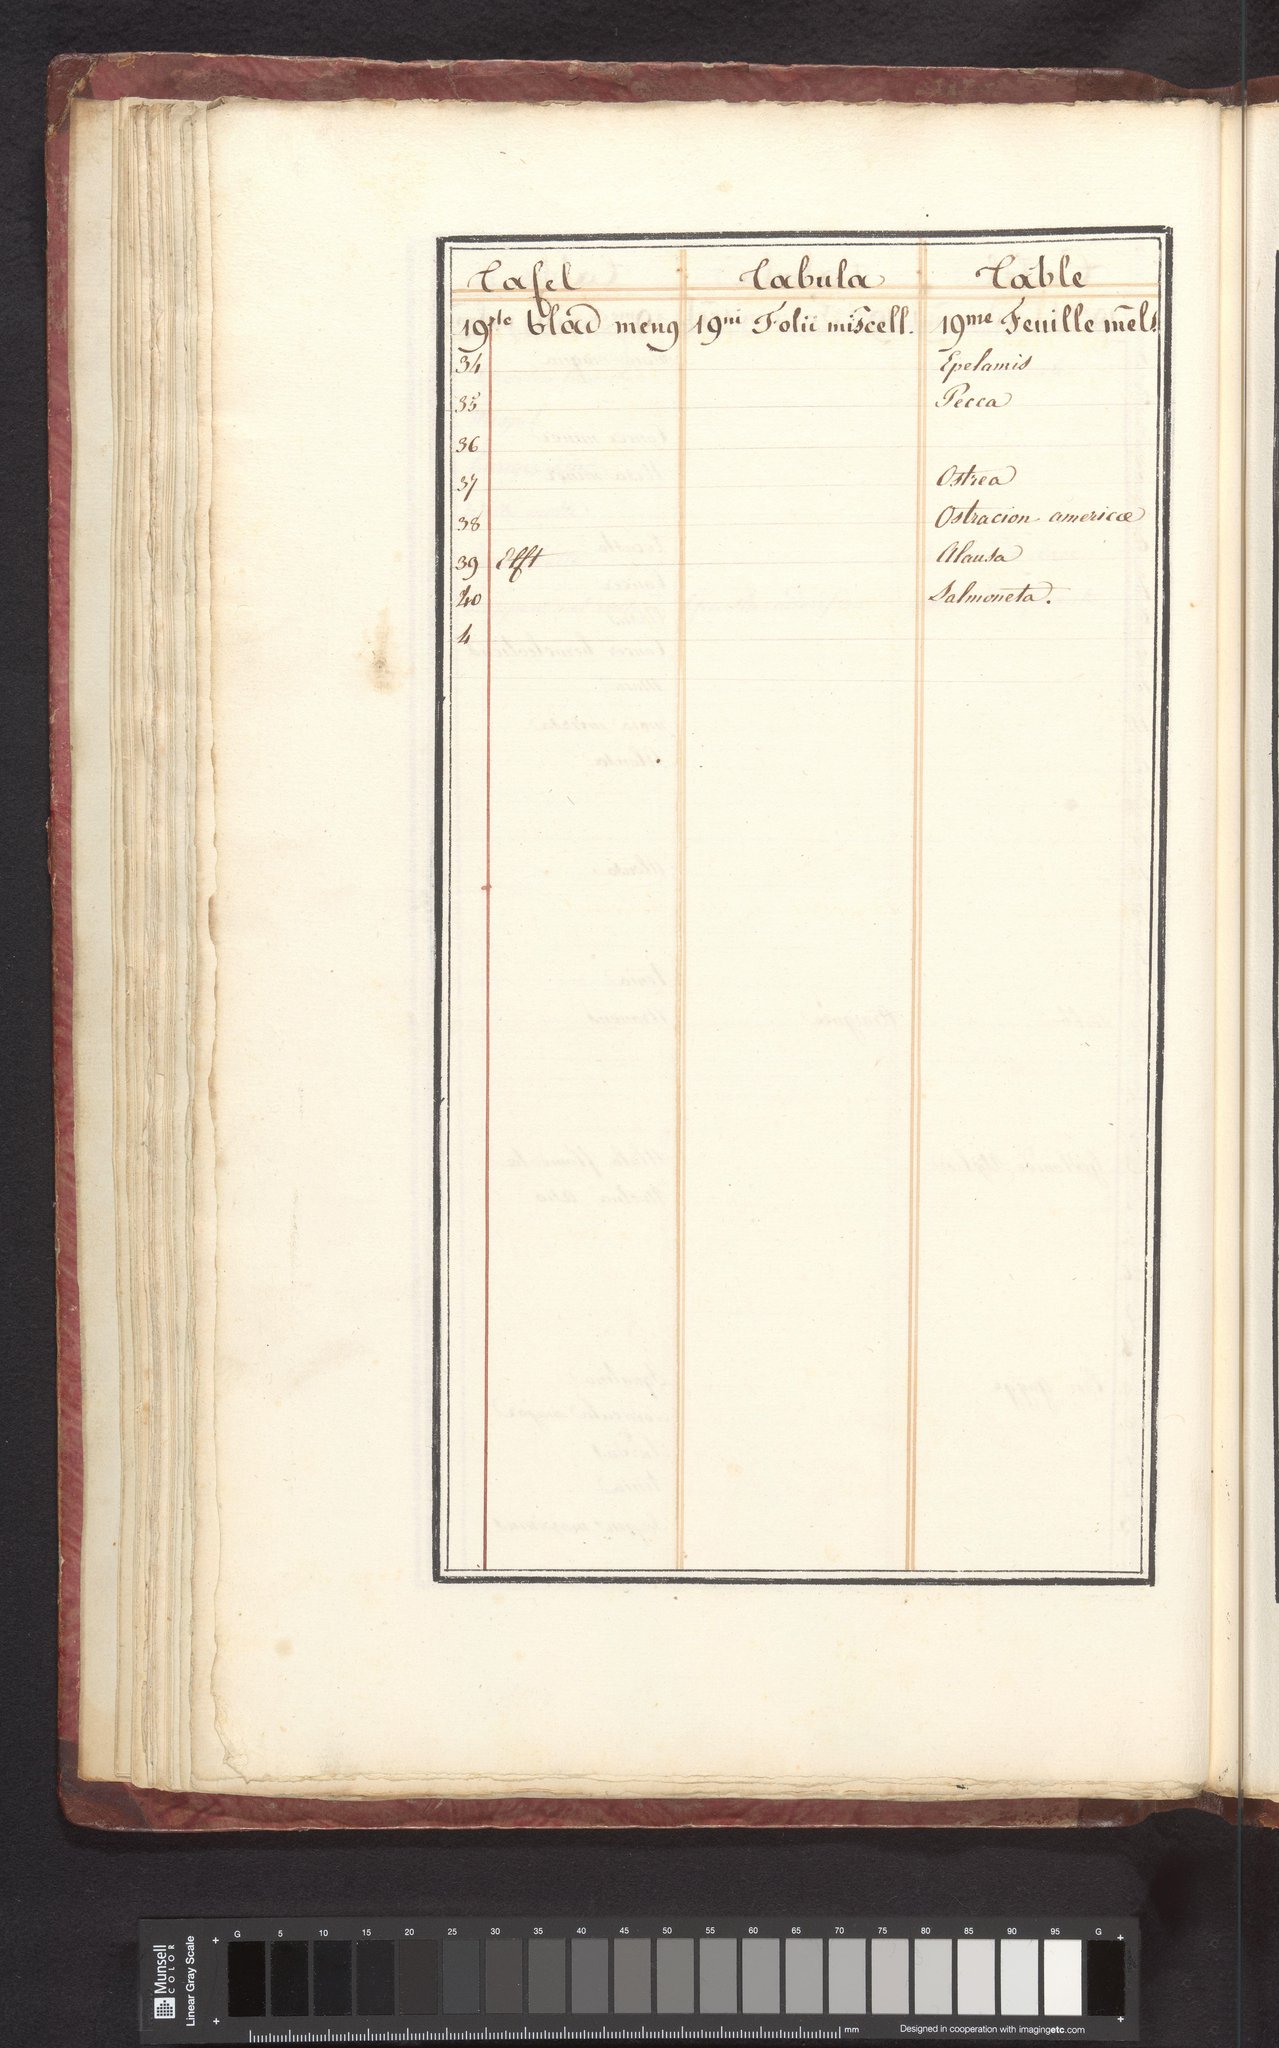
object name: manuscript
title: Tafel 19ste blad meng / Tabula 19ni Folii miscell / Table 19me Feuille mels.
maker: joseph van huerne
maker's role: kunstliefhebber, mecenas, verzamelaar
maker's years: 1752-1844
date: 1809-1814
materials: ink, paper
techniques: handwriting, pen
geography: bruges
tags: handwriting, written text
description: Schema met een lijst in drie kolommen van de dieren en planten afgebeeld in het negentiende ensemble (vervolg), nummers 34-40. Onderdeel van het zevende album met tekeningen van reptielen, amfibieën en natuurhistorische ensembles. Het zevende van twaalf albums met aquarellen van dieren, vogels en planten bekend rond 1600, gemaakt in opdracht van keizer Rudolf II. Met toelichting in Nederlands, Latijn en Frans.